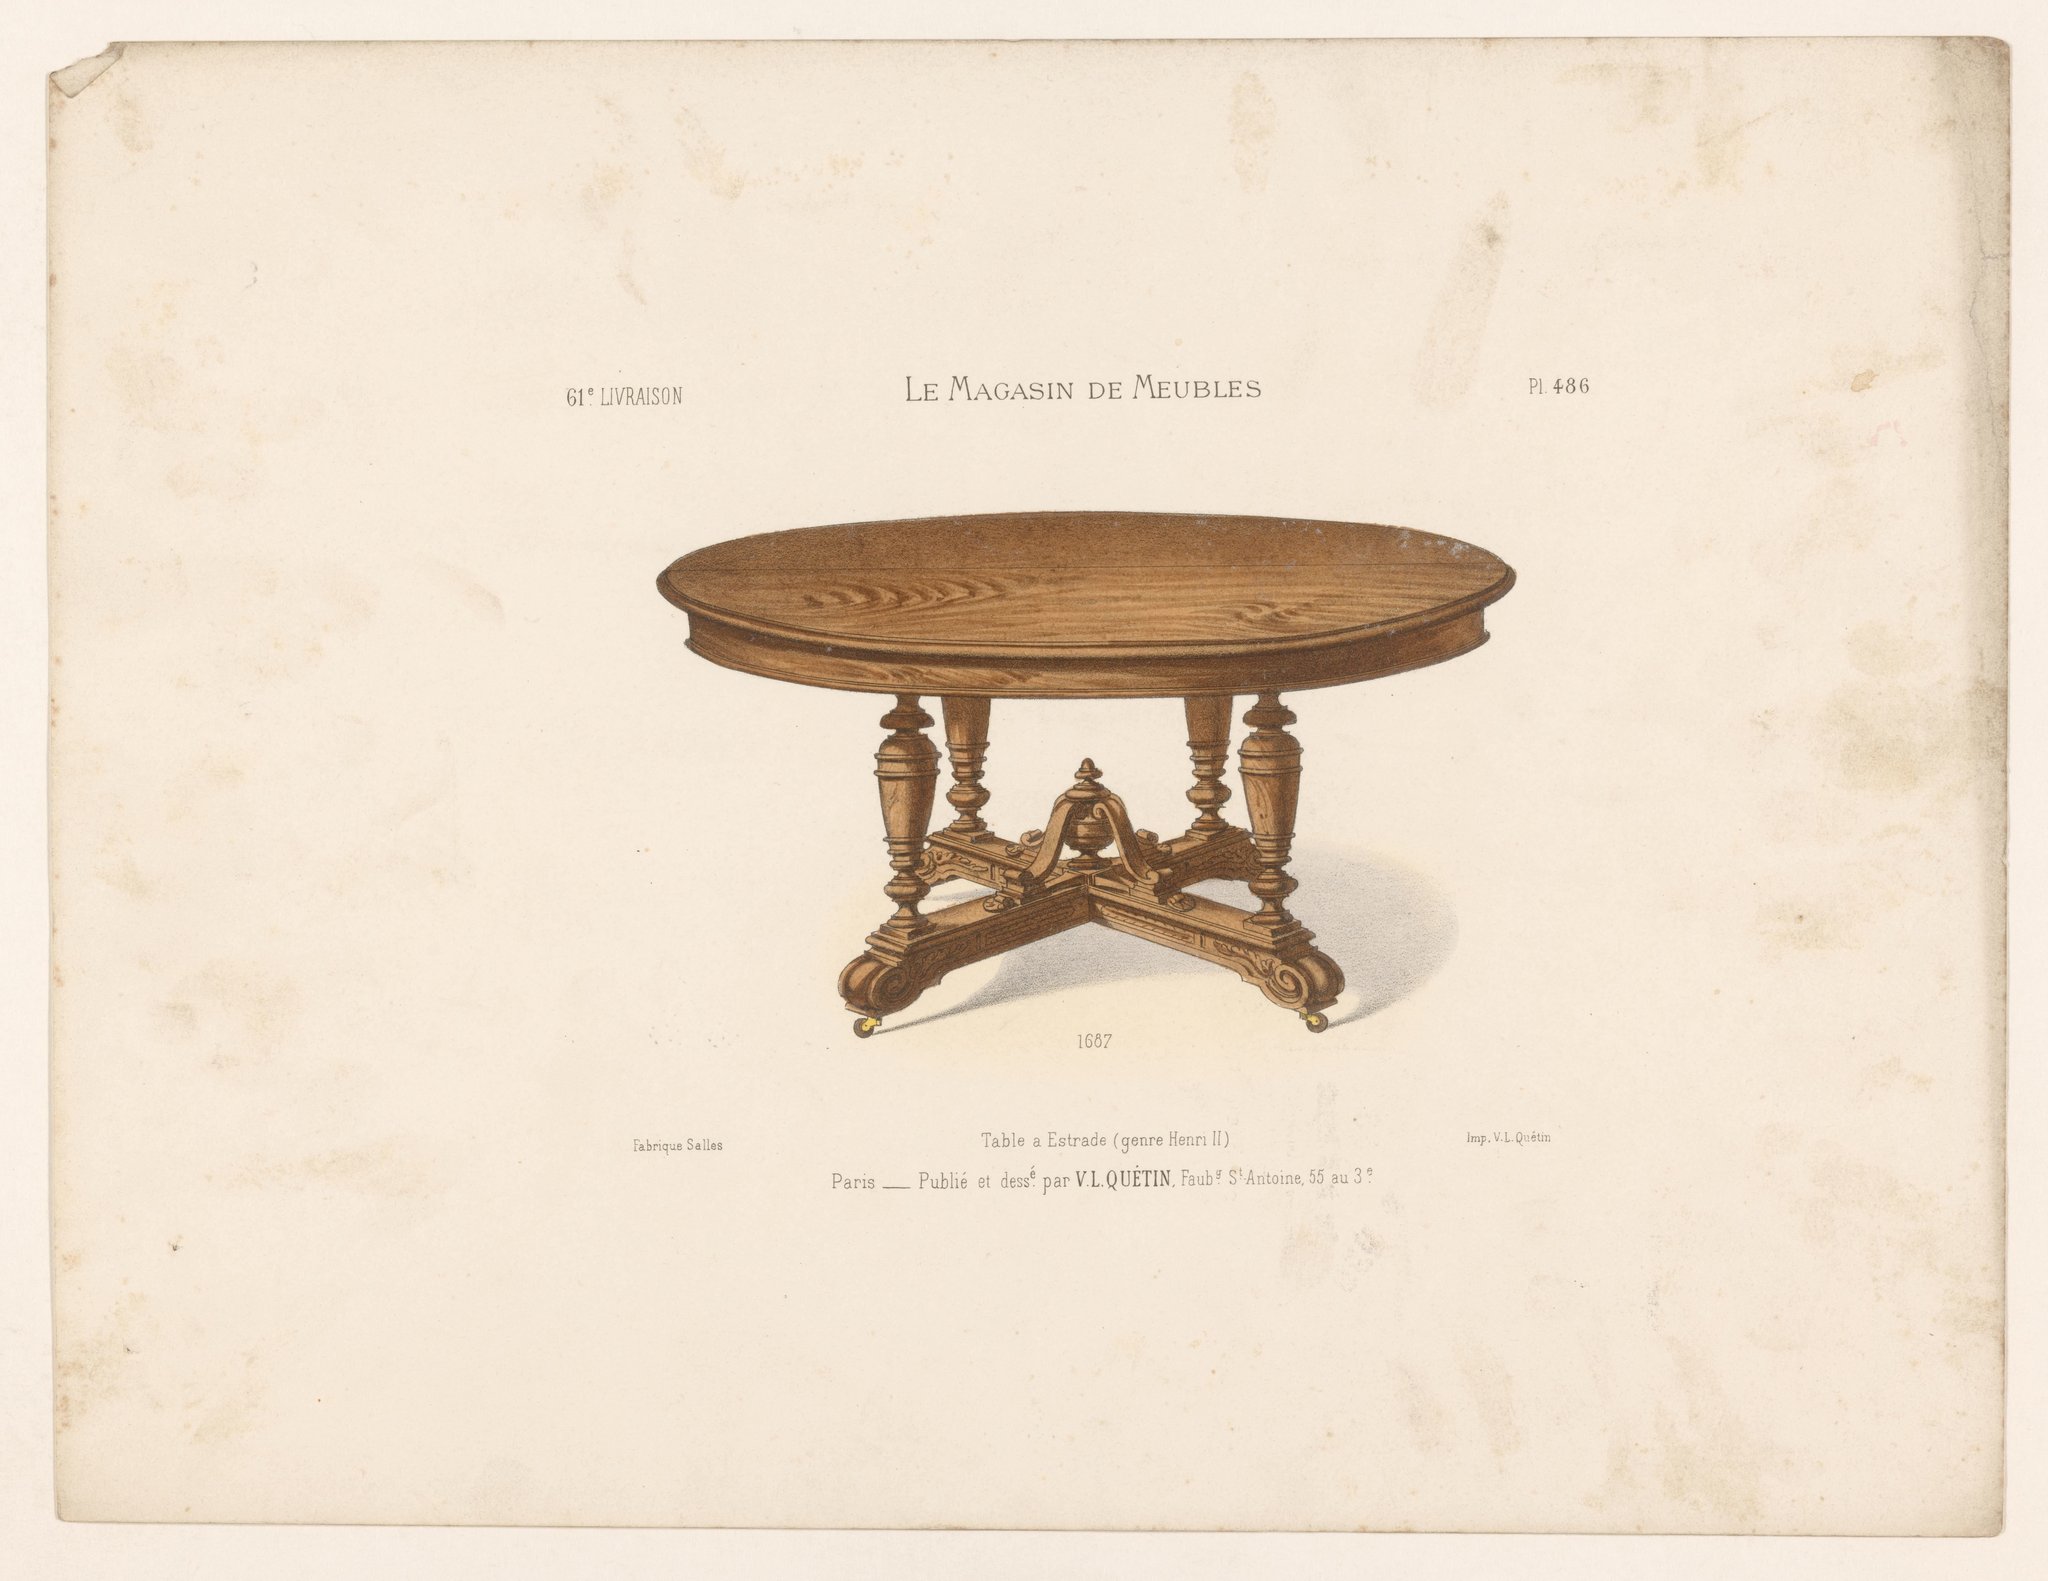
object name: print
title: Tafel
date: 1878-1904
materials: paper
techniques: hand coloring, lithograph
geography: paris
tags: table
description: Een ovale tafel in de Hendrik II-stijl. Prent uit 61e Livraison.